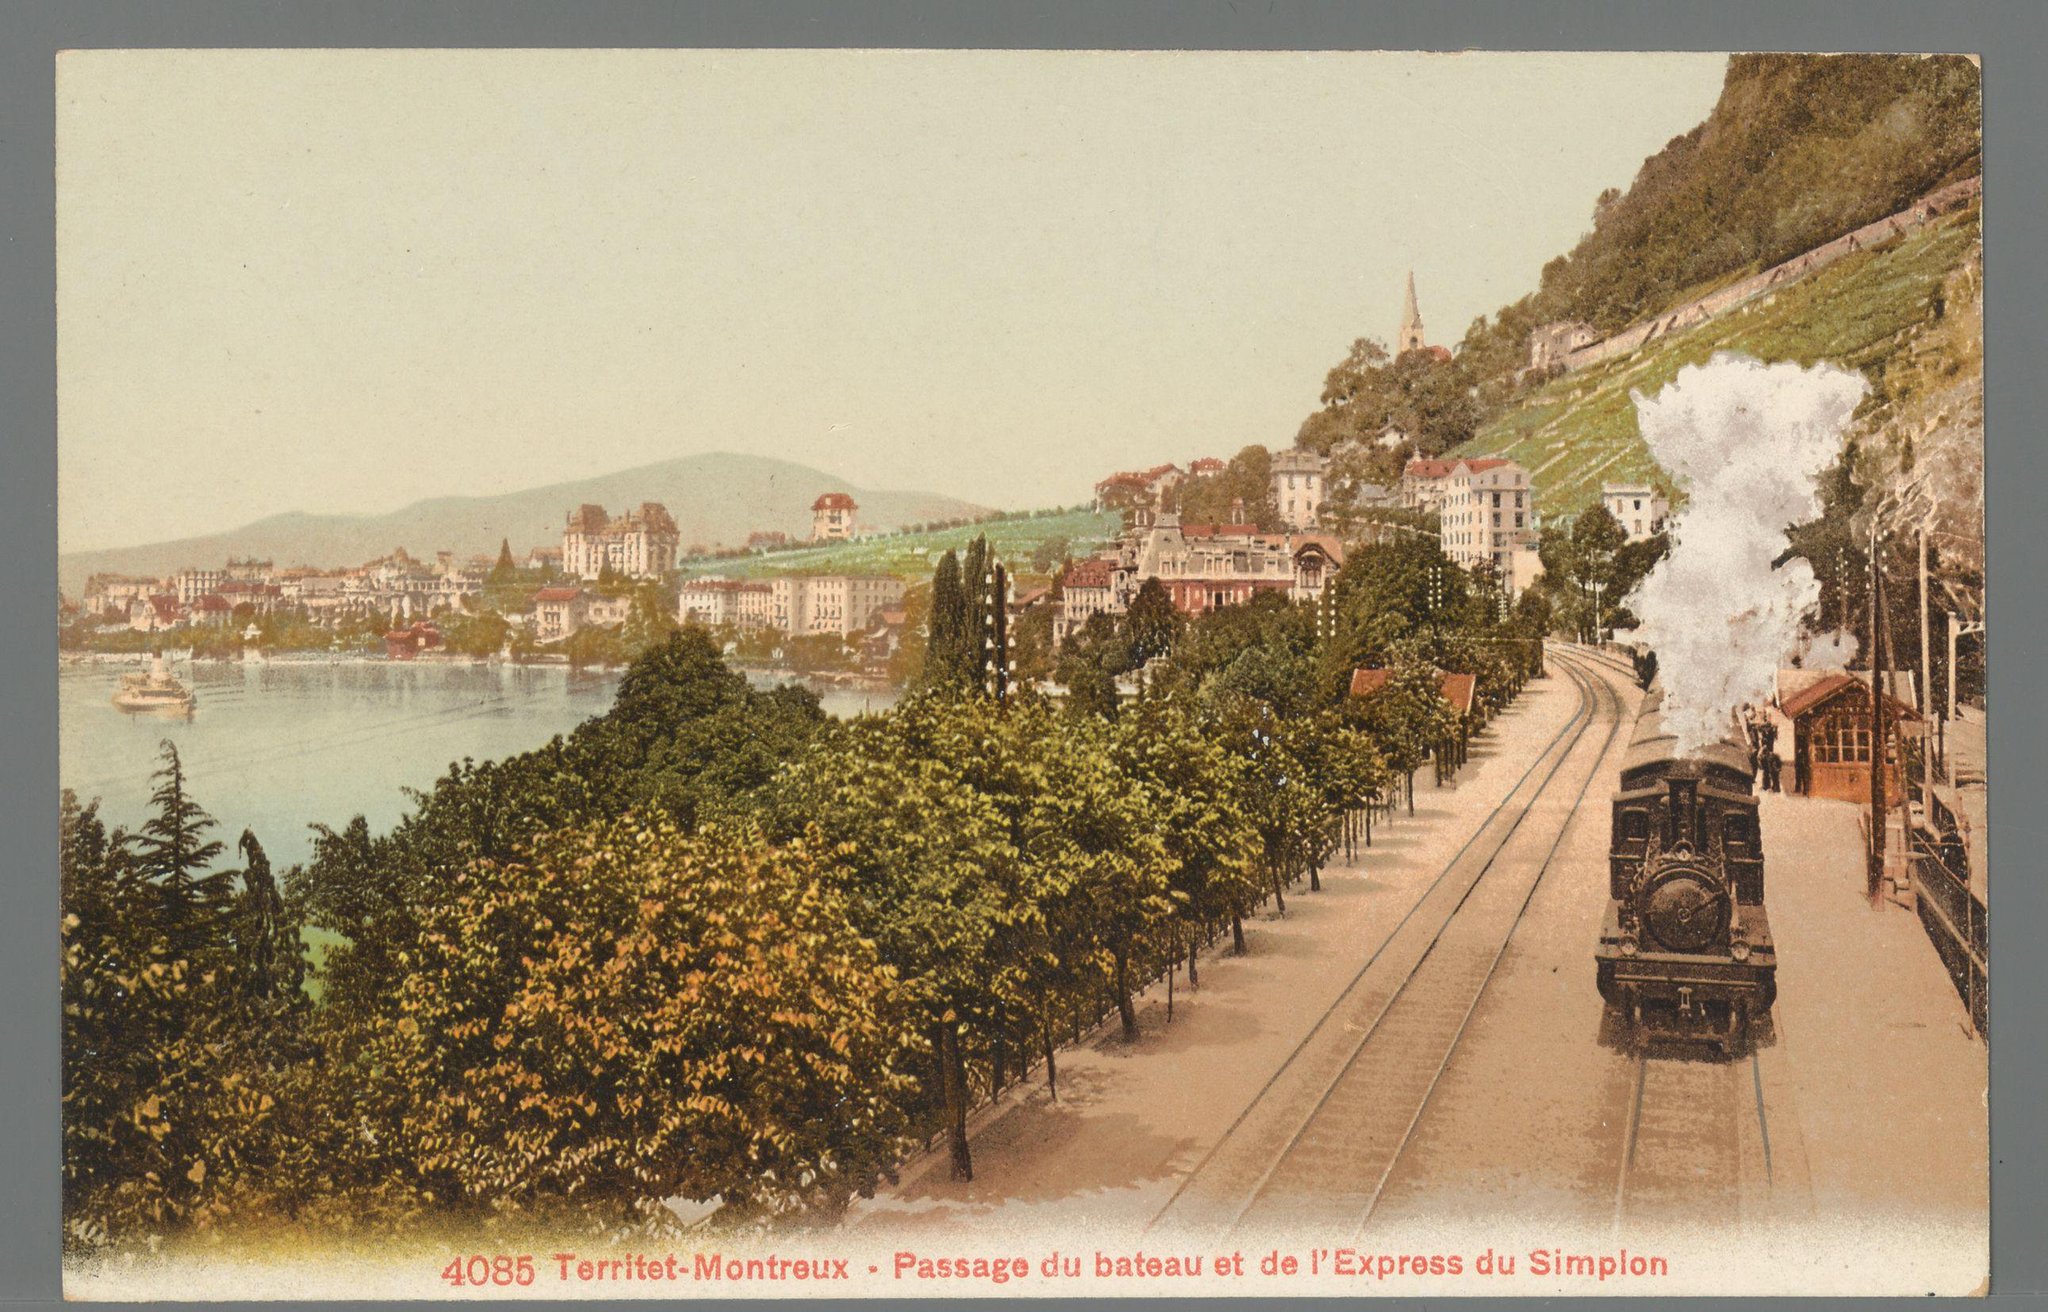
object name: photomechanical print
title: Territet-Montreux - Passage du bateau et de l'Express du Simplon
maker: Anonymous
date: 1905-1930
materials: cardboard, photographic process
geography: zurich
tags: city-view, and landscape with man-made constructions, pond, steam locomotive